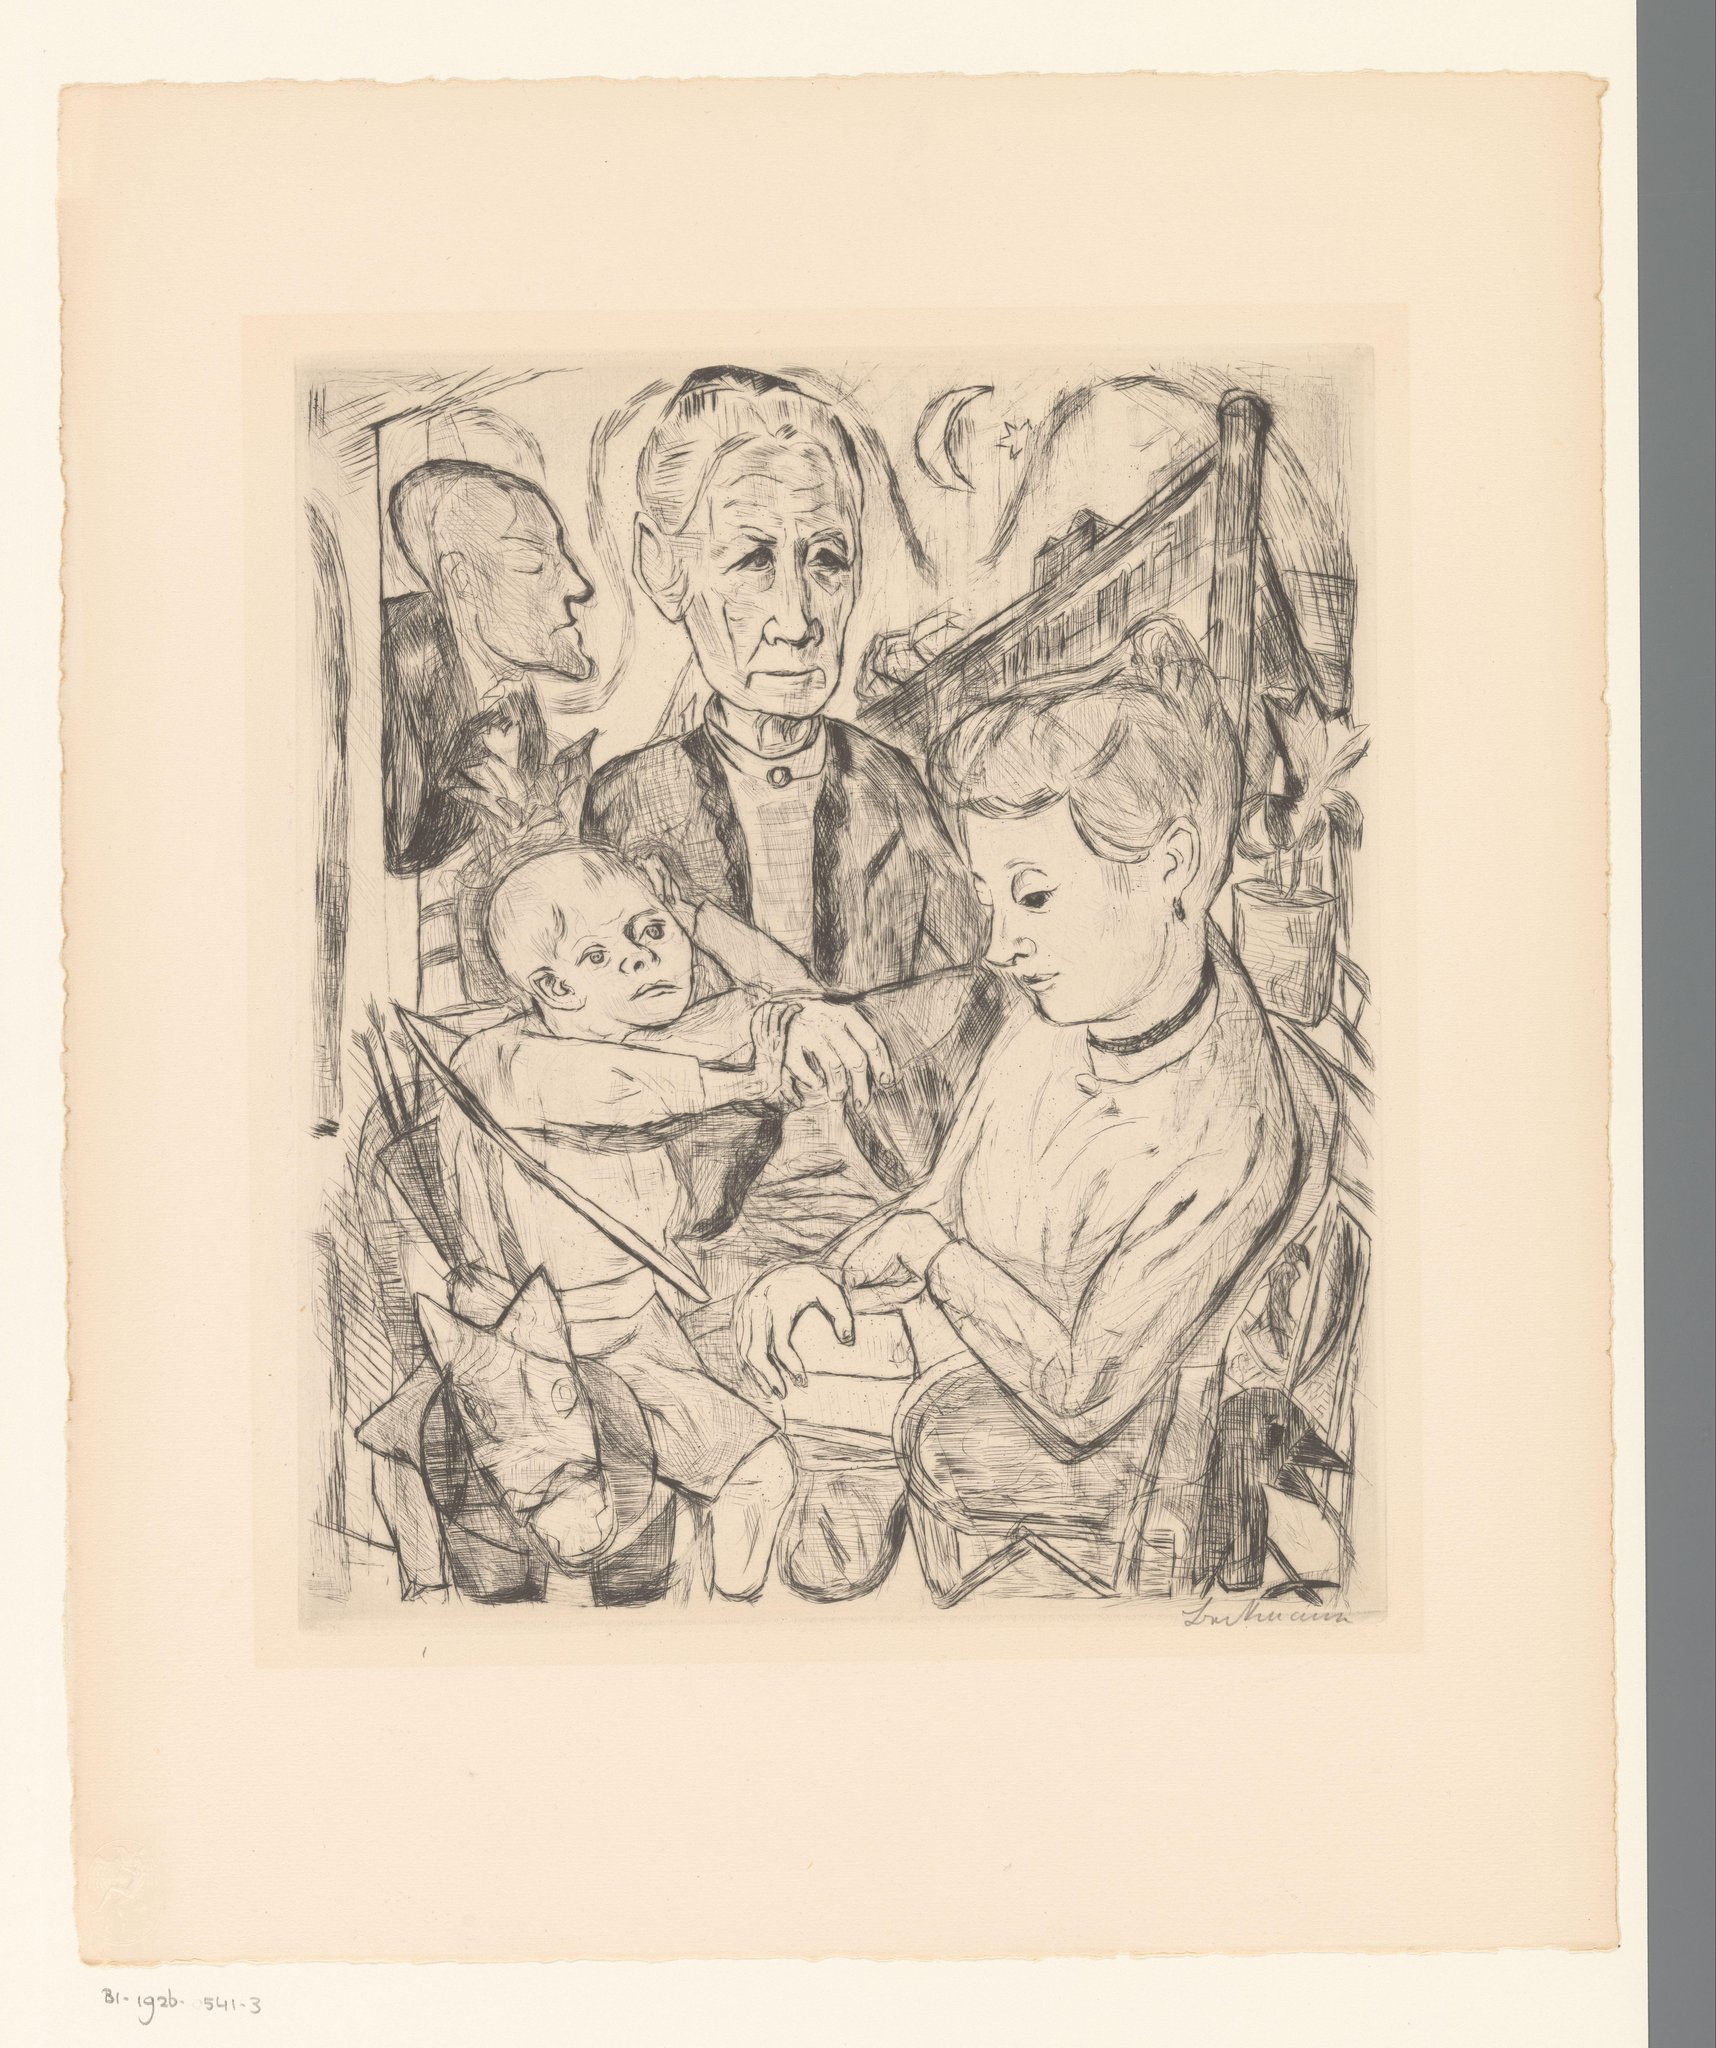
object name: print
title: Interieur met drie generaties van een familie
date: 1918-1919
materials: paper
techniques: drypoint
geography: munich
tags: family, relationship, descent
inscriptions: collector's mark: Lugt 5629, collector's mark: Lugt 2166